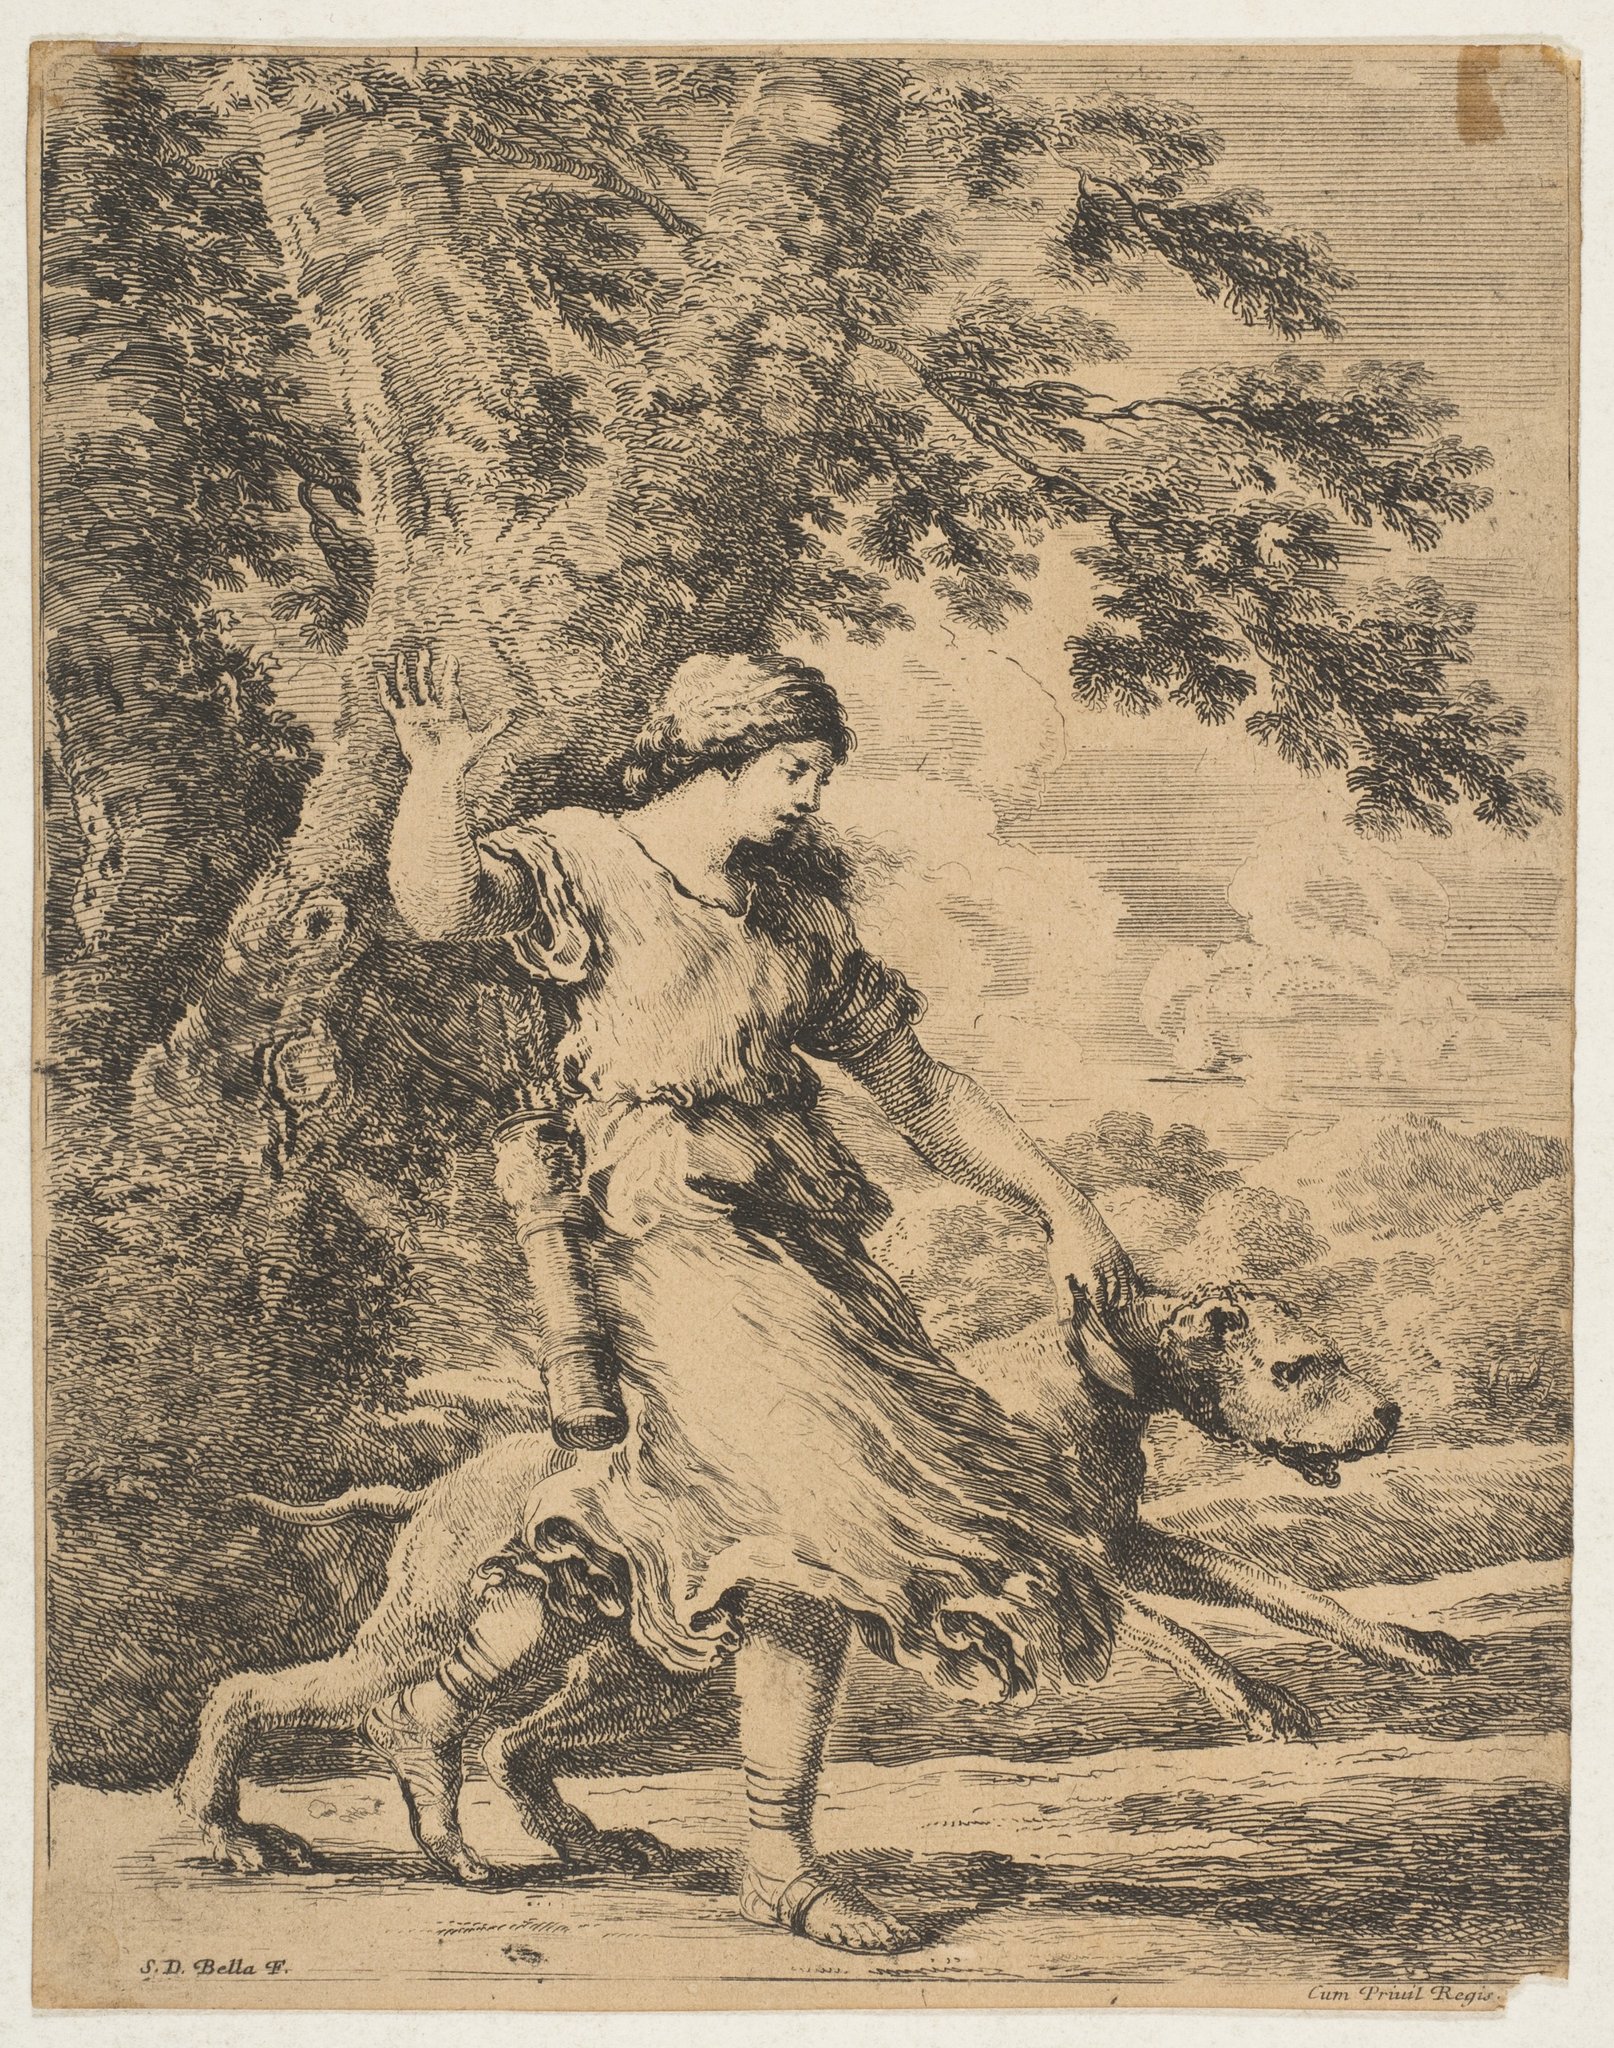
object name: print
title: A Nymph Holding a Large Dog by its Collar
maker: stefano della bella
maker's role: artist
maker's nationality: italian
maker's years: 1610-1664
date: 1654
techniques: etching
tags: nymphs,dogs,trees